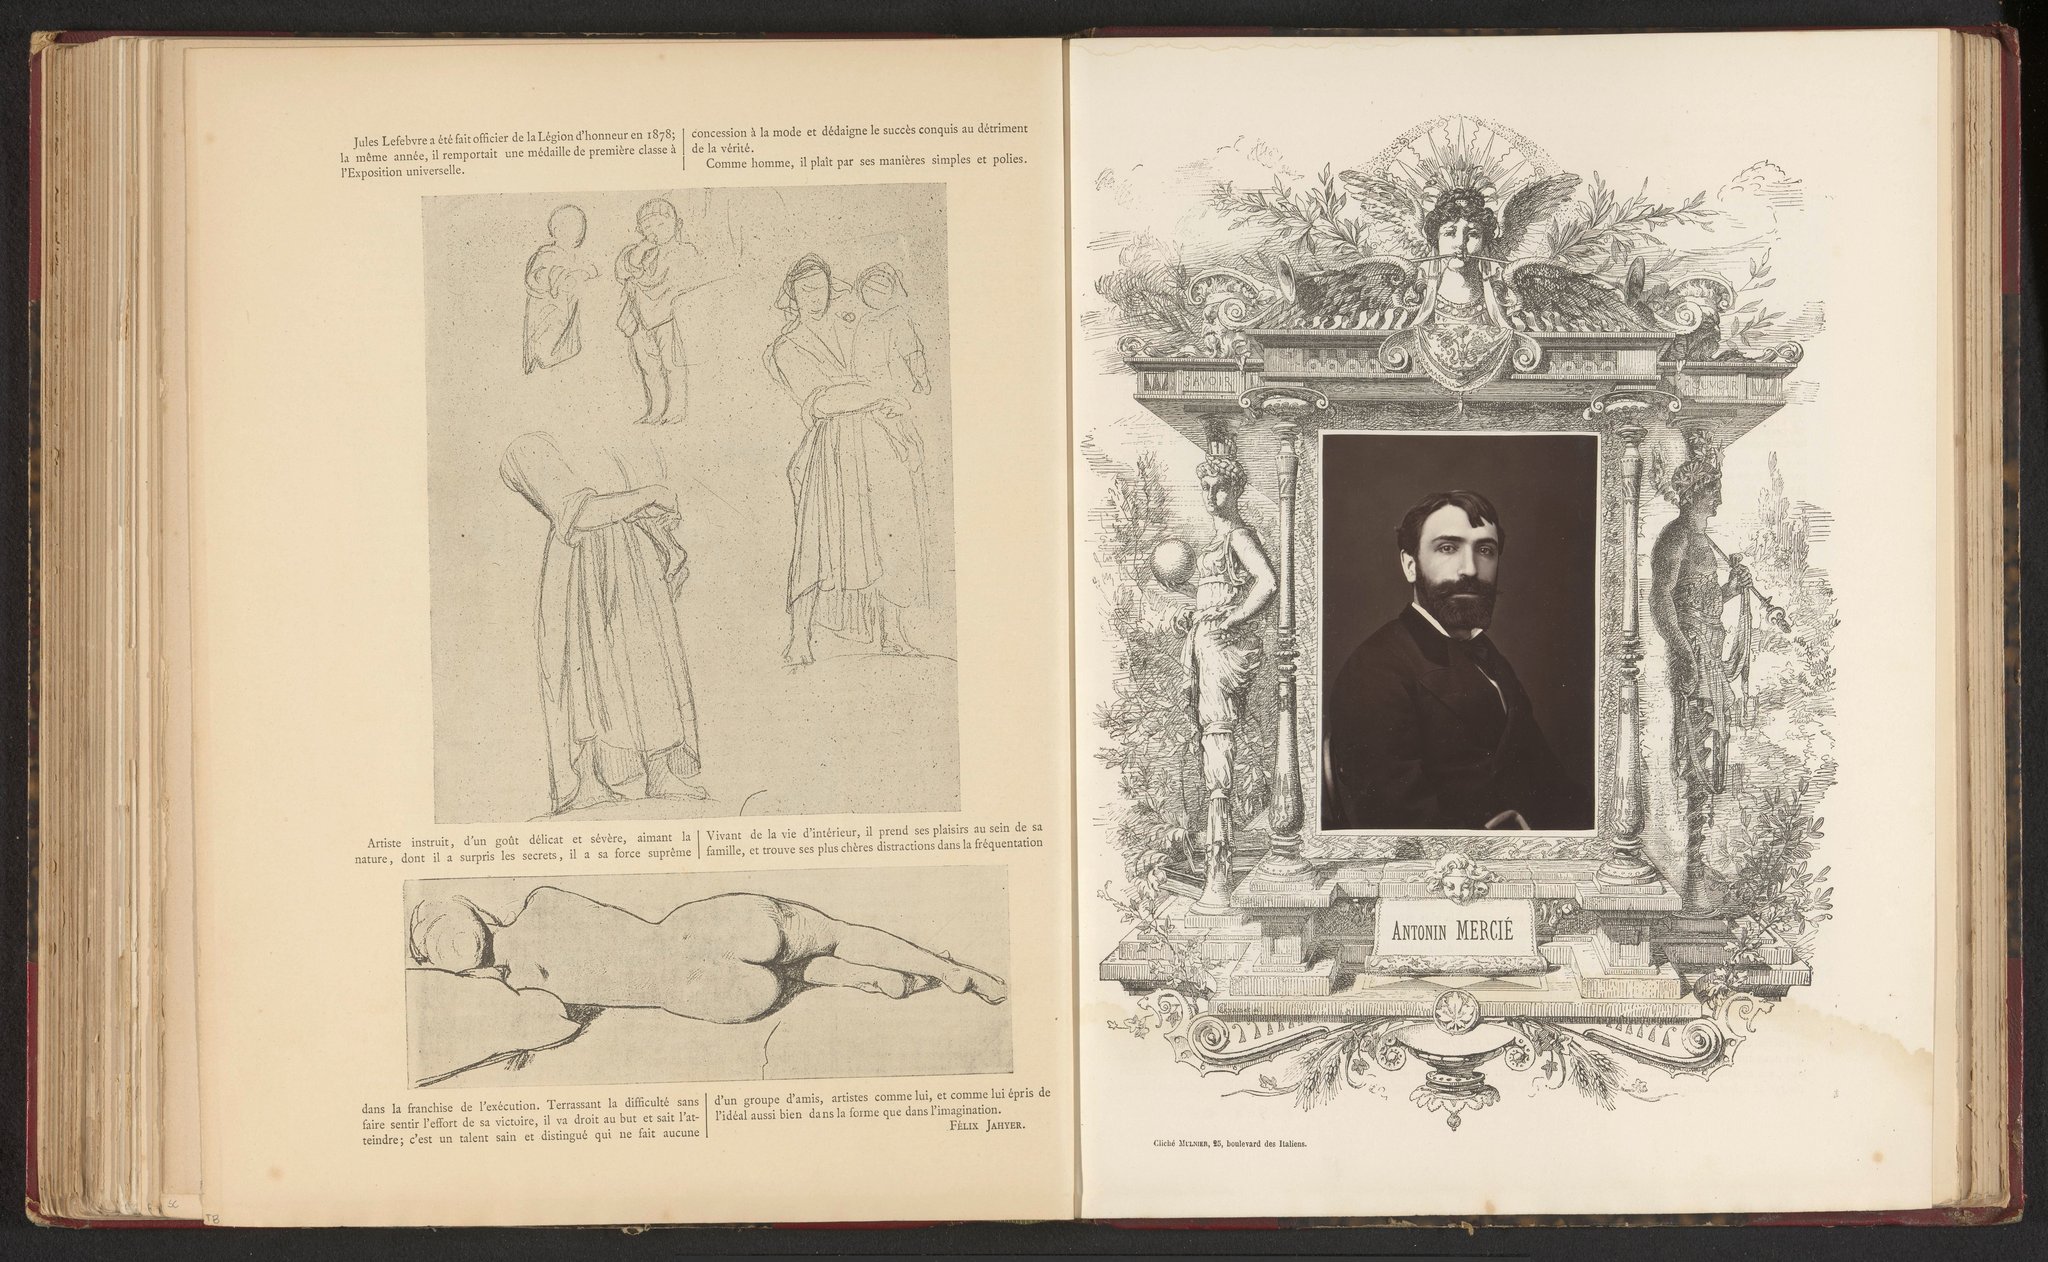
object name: photomechanical print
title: Portret van Marius Jean Antonin Mercié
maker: mulnier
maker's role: fotograaf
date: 1876-1879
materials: paper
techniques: woodburytype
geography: paris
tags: paris, sculptor, marius jean antonin mercié, portrait, self-portrait of sculptor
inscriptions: inscription: ‘25, boulevard des Italiens.’